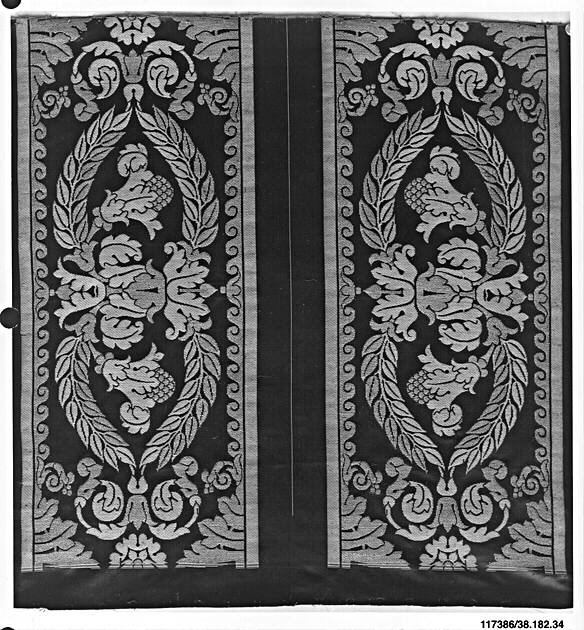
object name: border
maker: séguin et cie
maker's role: manufacturer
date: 1805-1815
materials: metal thread, silk